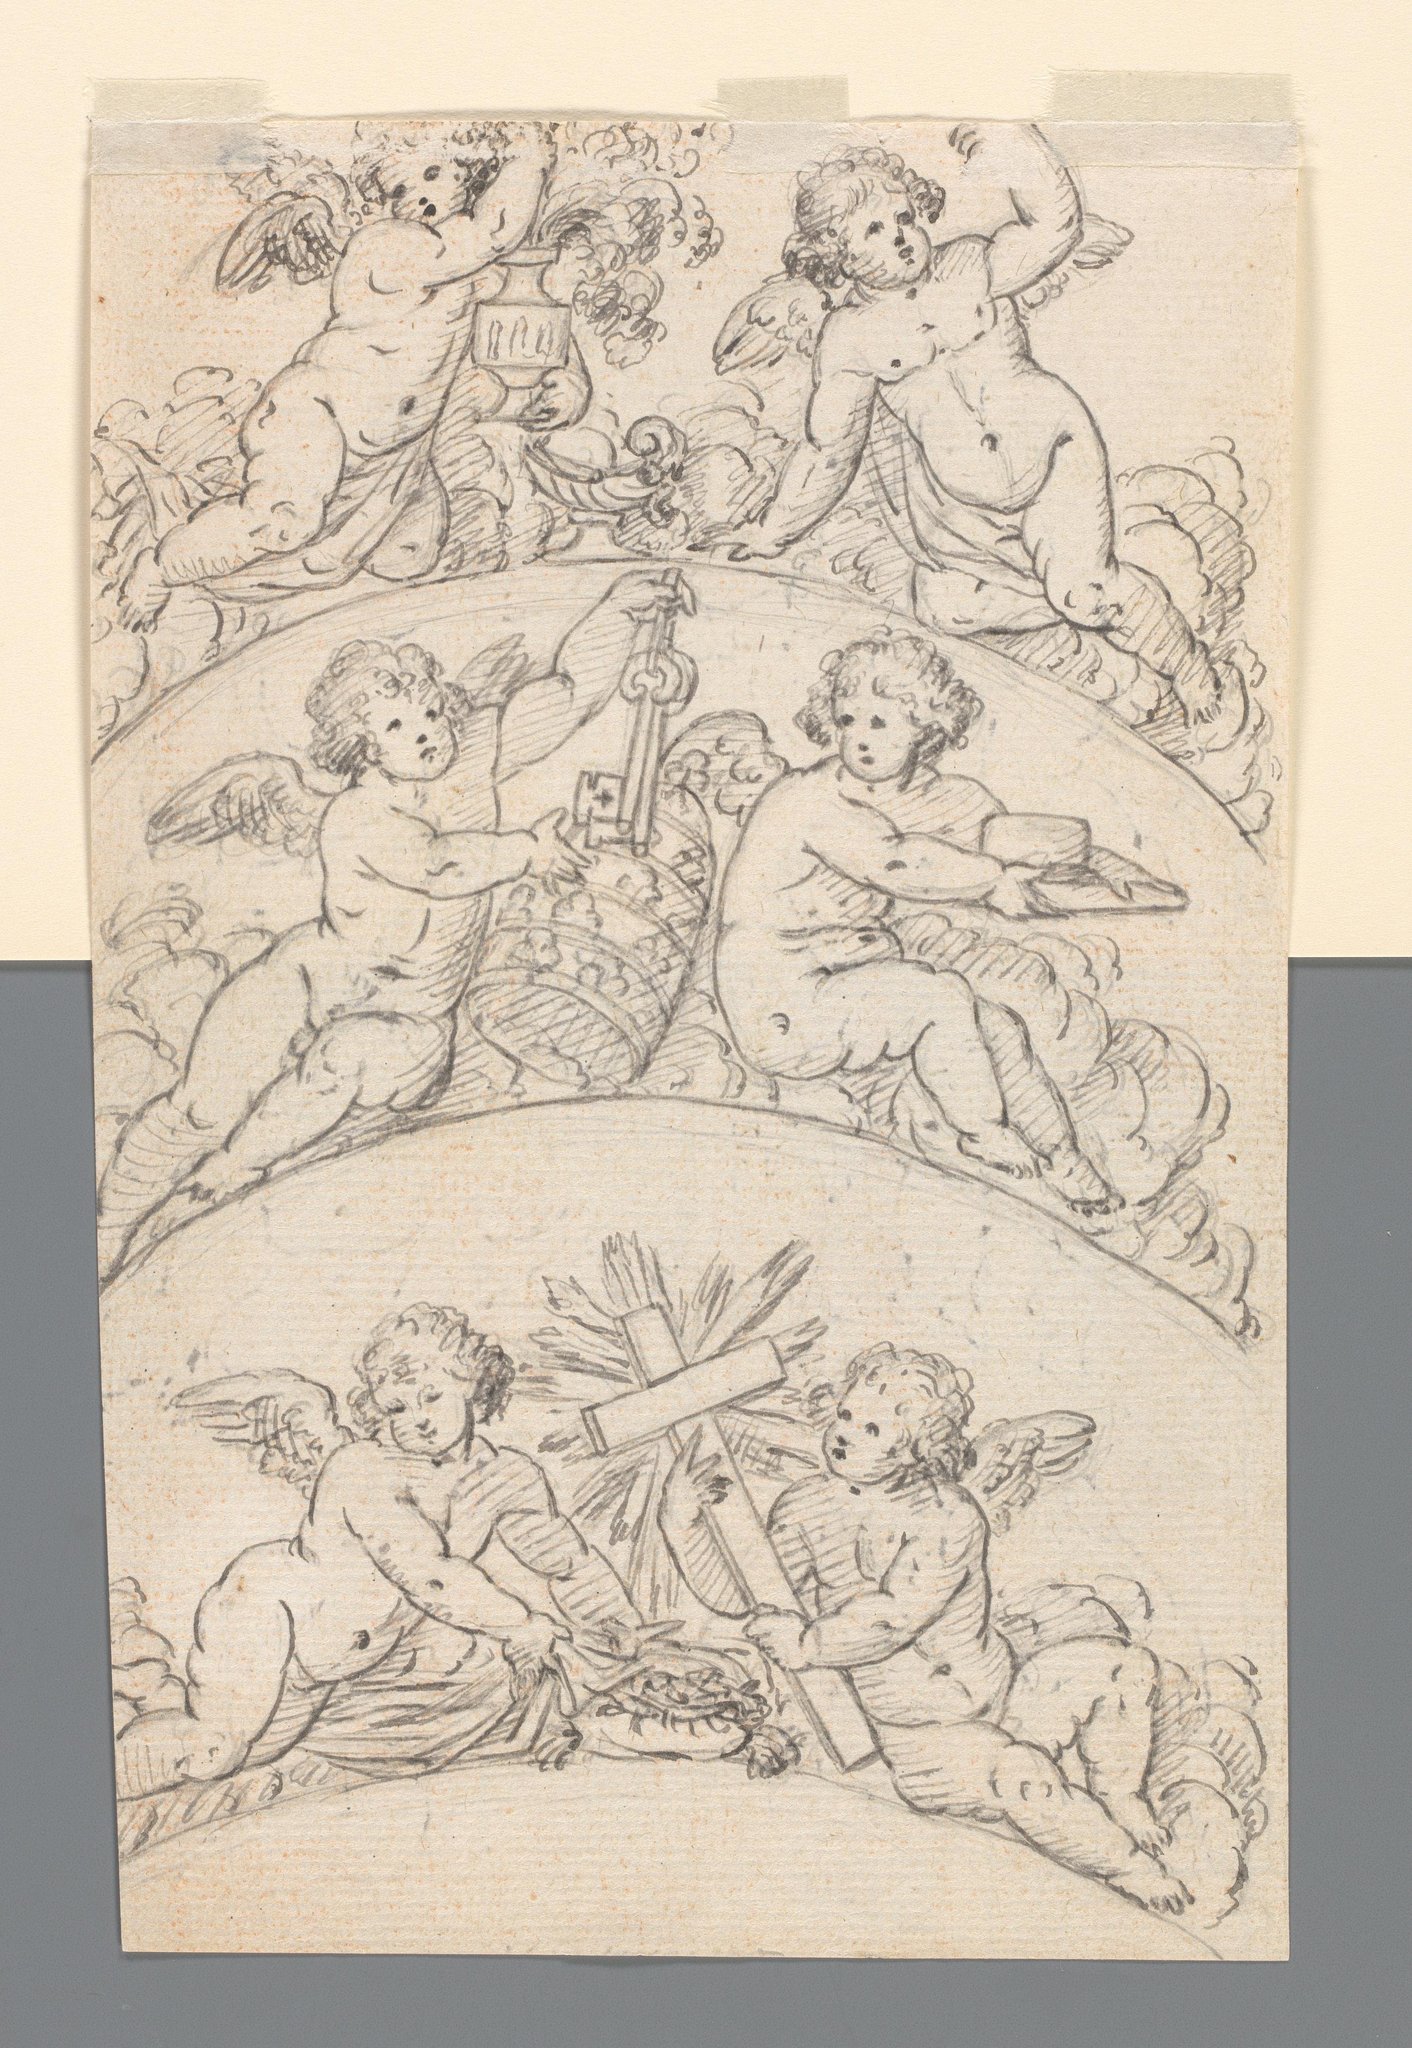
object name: drawing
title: Putti met religieuze attributen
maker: Anonymous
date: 1773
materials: ink, paper, pencil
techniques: pen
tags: (liturgical) equipment of church, cupids: 'amores', 'amoretti', 'putti'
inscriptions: collector's mark: Lugt 2228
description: Drie ontwerpen voor decoraties van telkens twee putti met religieuze attributen zoals een wierookvat, de pauselijke tiara en sleutels en een kruis.